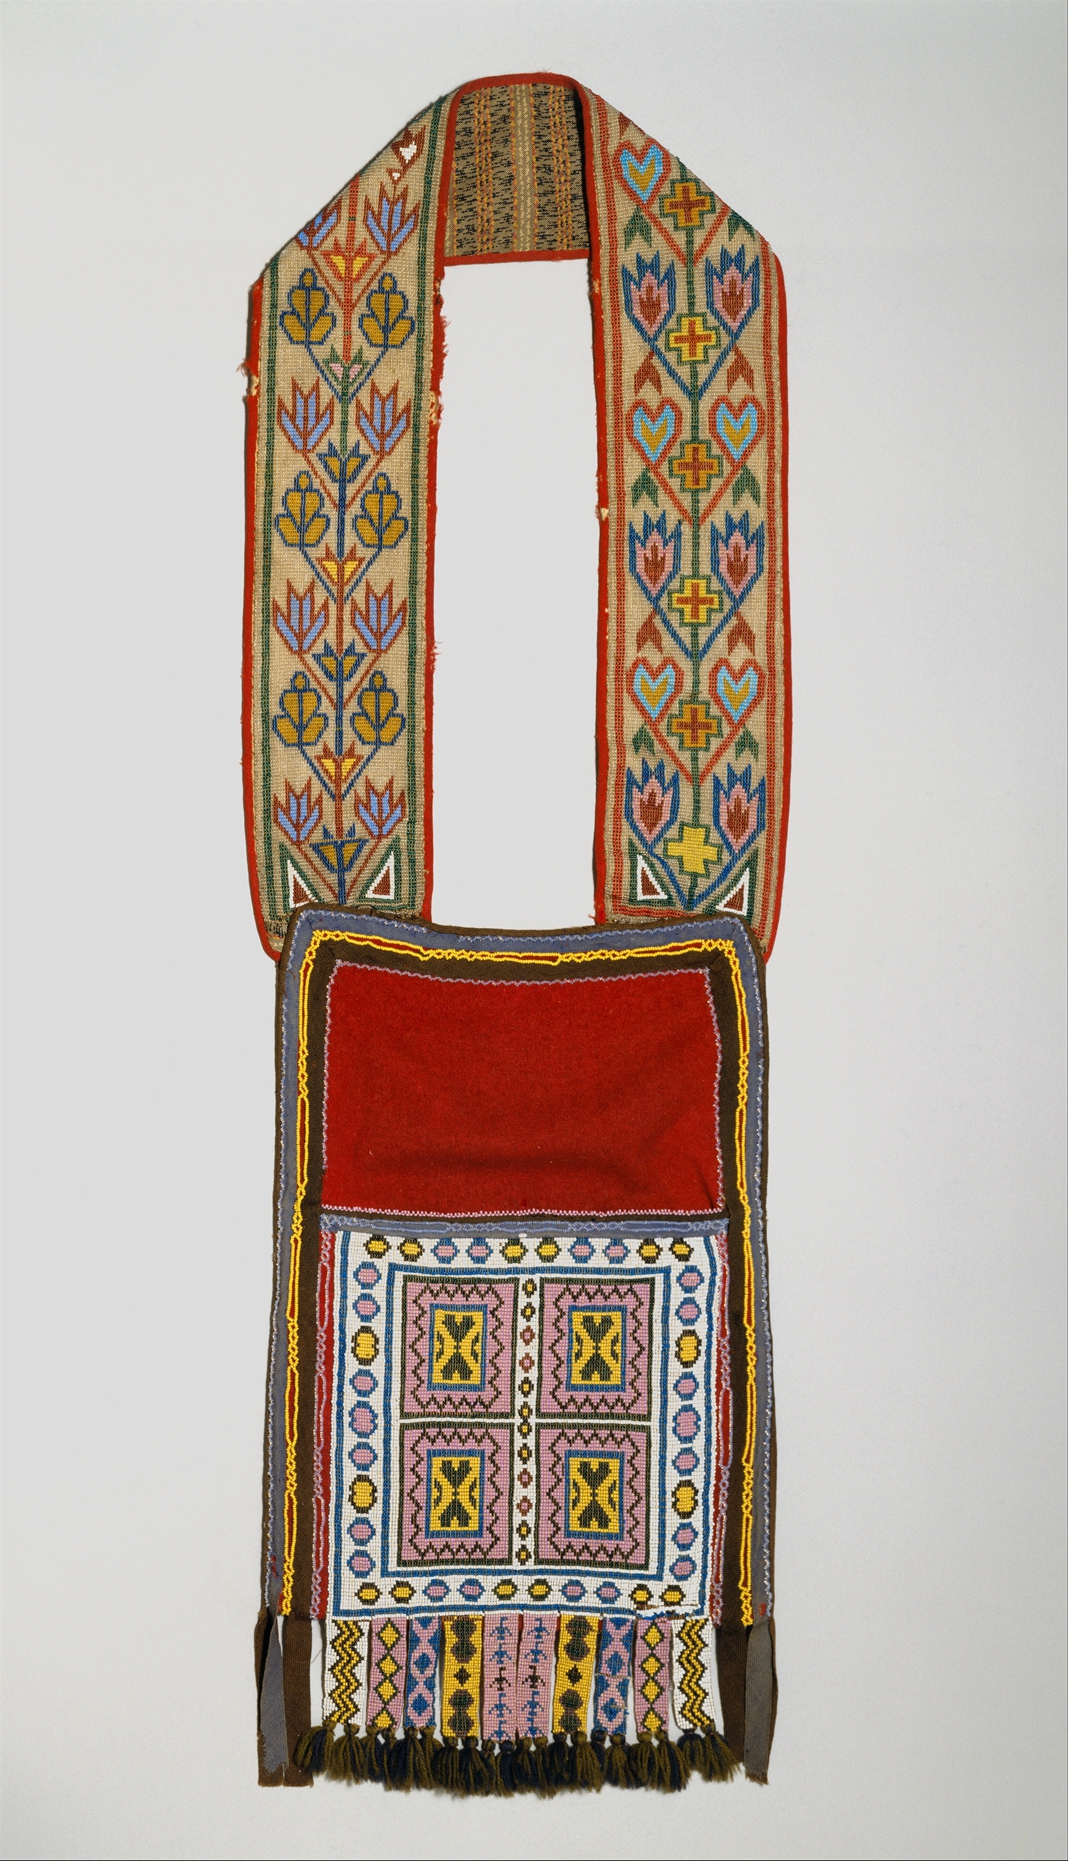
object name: bag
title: Bandolier Bag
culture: ojibwa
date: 1870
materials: cotton, glass, wool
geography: united states